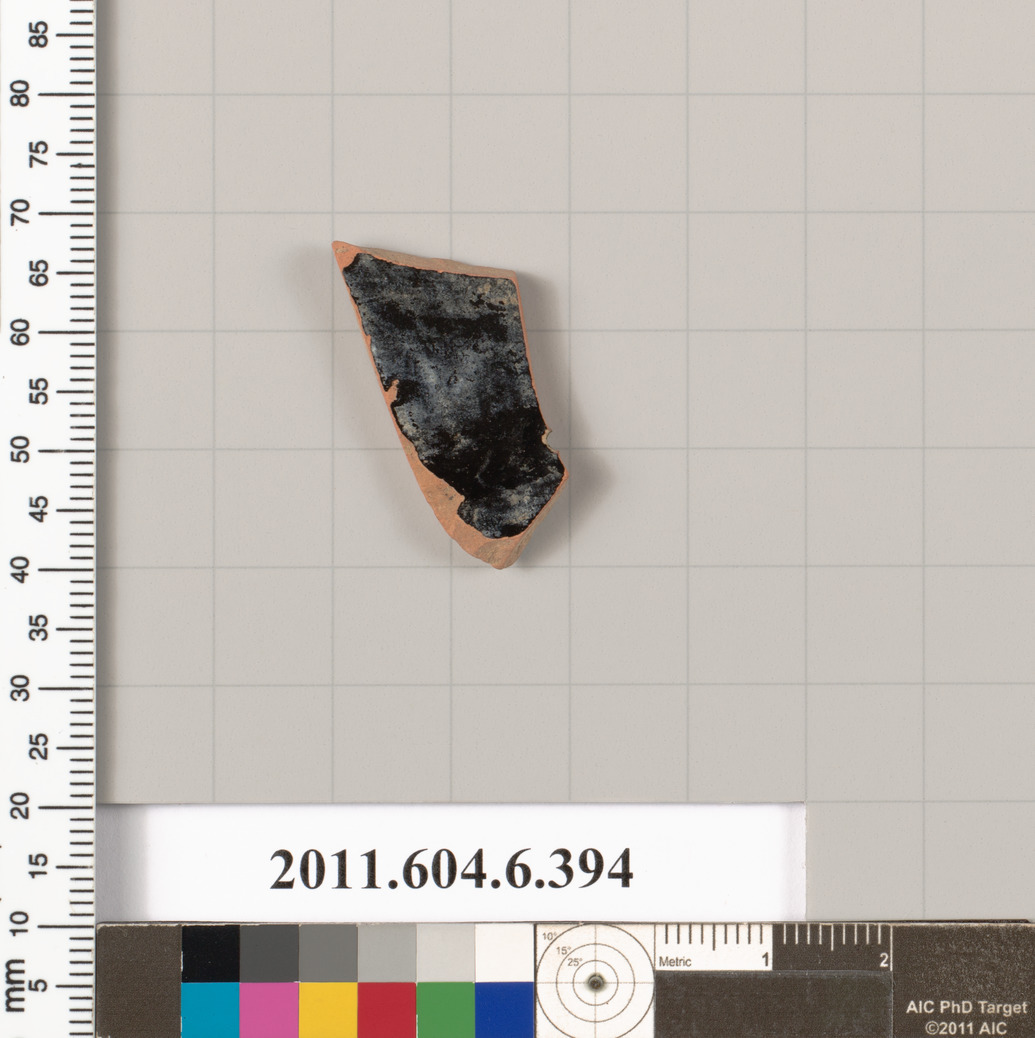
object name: undetermined open shape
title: Terracotta fragment of an open shape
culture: greek, attic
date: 600-401 BCE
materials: terracotta